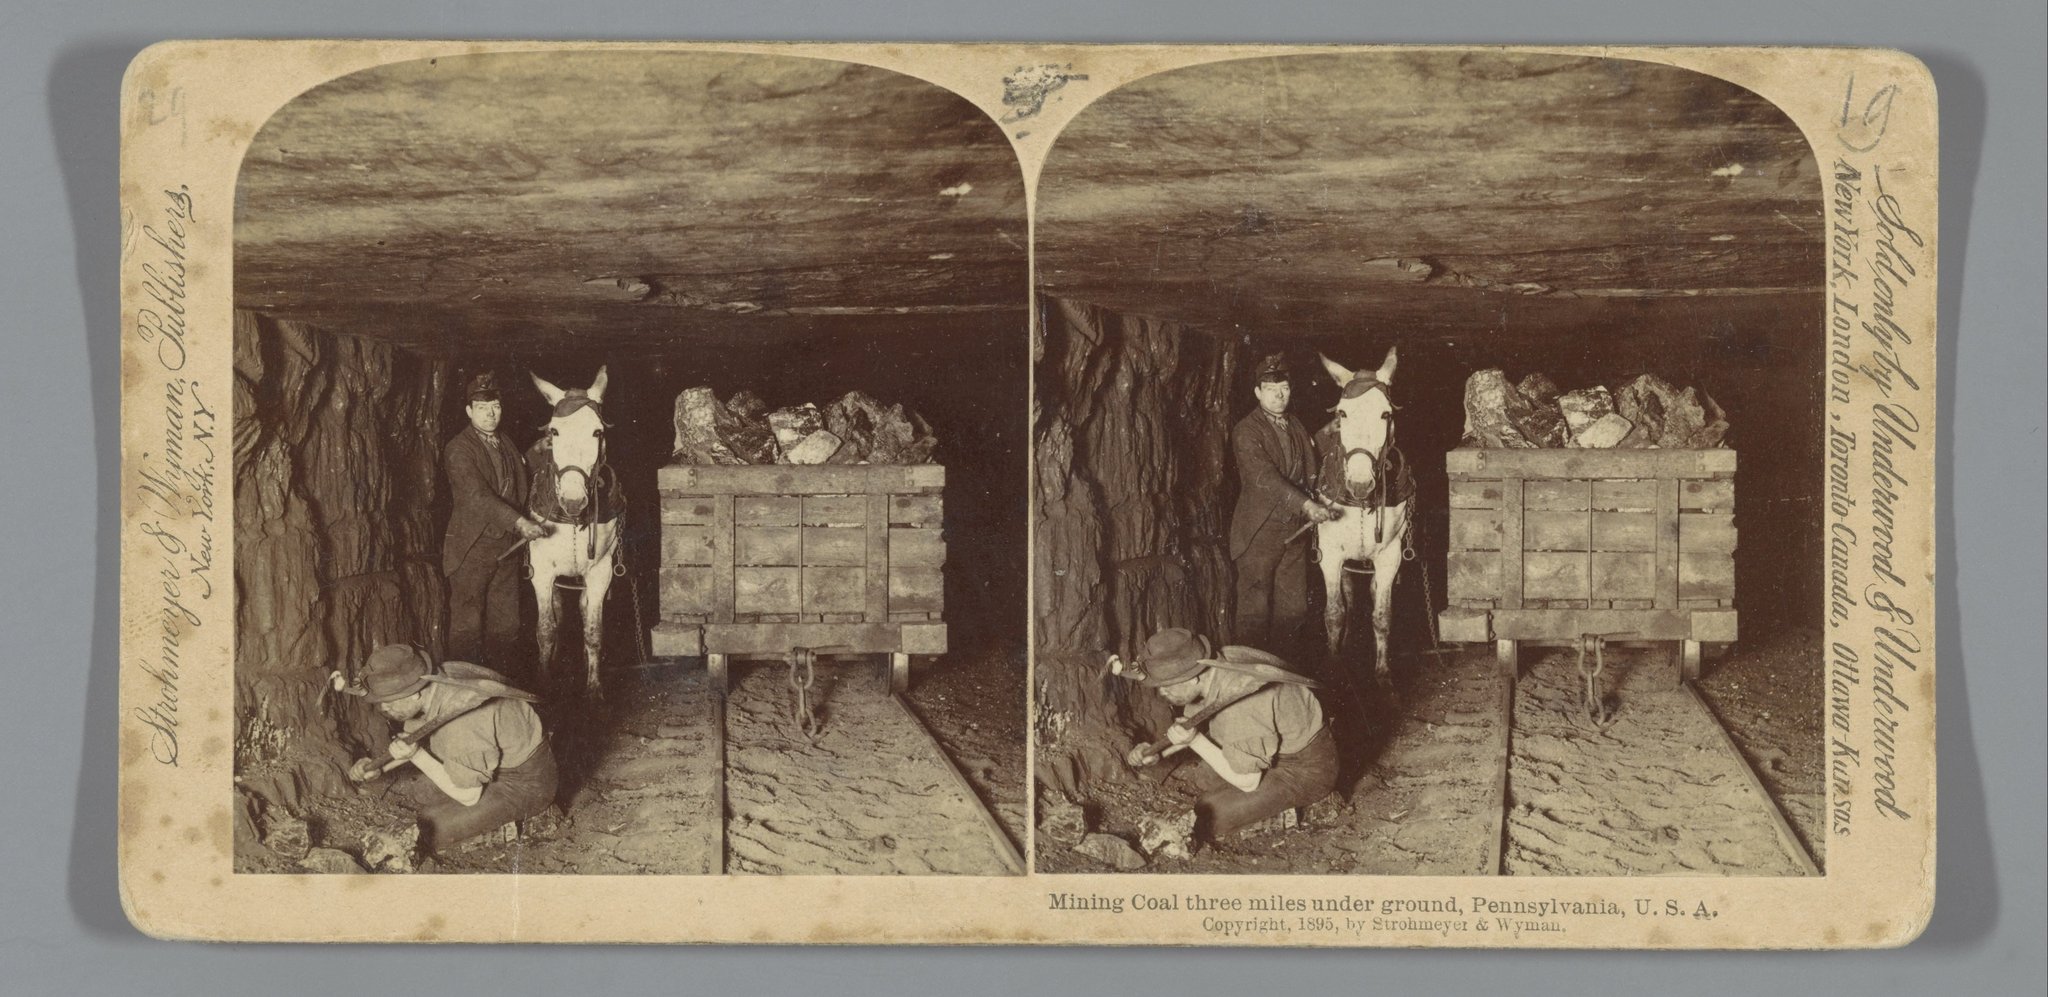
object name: stereograph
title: Mijnwerkers in een kolenmijn in Pennsylvania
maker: Anonymous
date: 1895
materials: cardboard, paper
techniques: albumen print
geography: new york city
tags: shafts and galleries (of a mine)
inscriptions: number: ‘19’, copyright notice: ‘Copyright, 1895, by Strohmeyer & Wyman.’, title: ‘Mining Coal Three Miles Underground, Pennsylvania, U. S. A.’